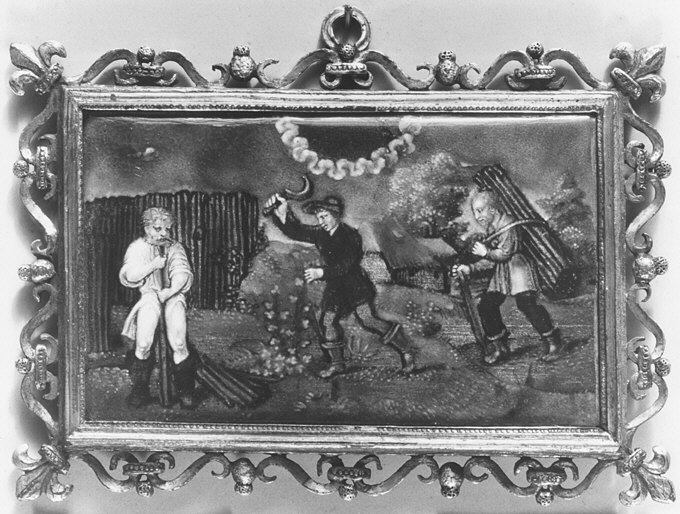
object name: plaque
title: The Labors of the Months: Cutting Faggots (March)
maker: jean ii pénicaud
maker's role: maker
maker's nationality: french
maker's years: 1524-1554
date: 1534-1566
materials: copper, enamel, gilt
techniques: painting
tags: men,working